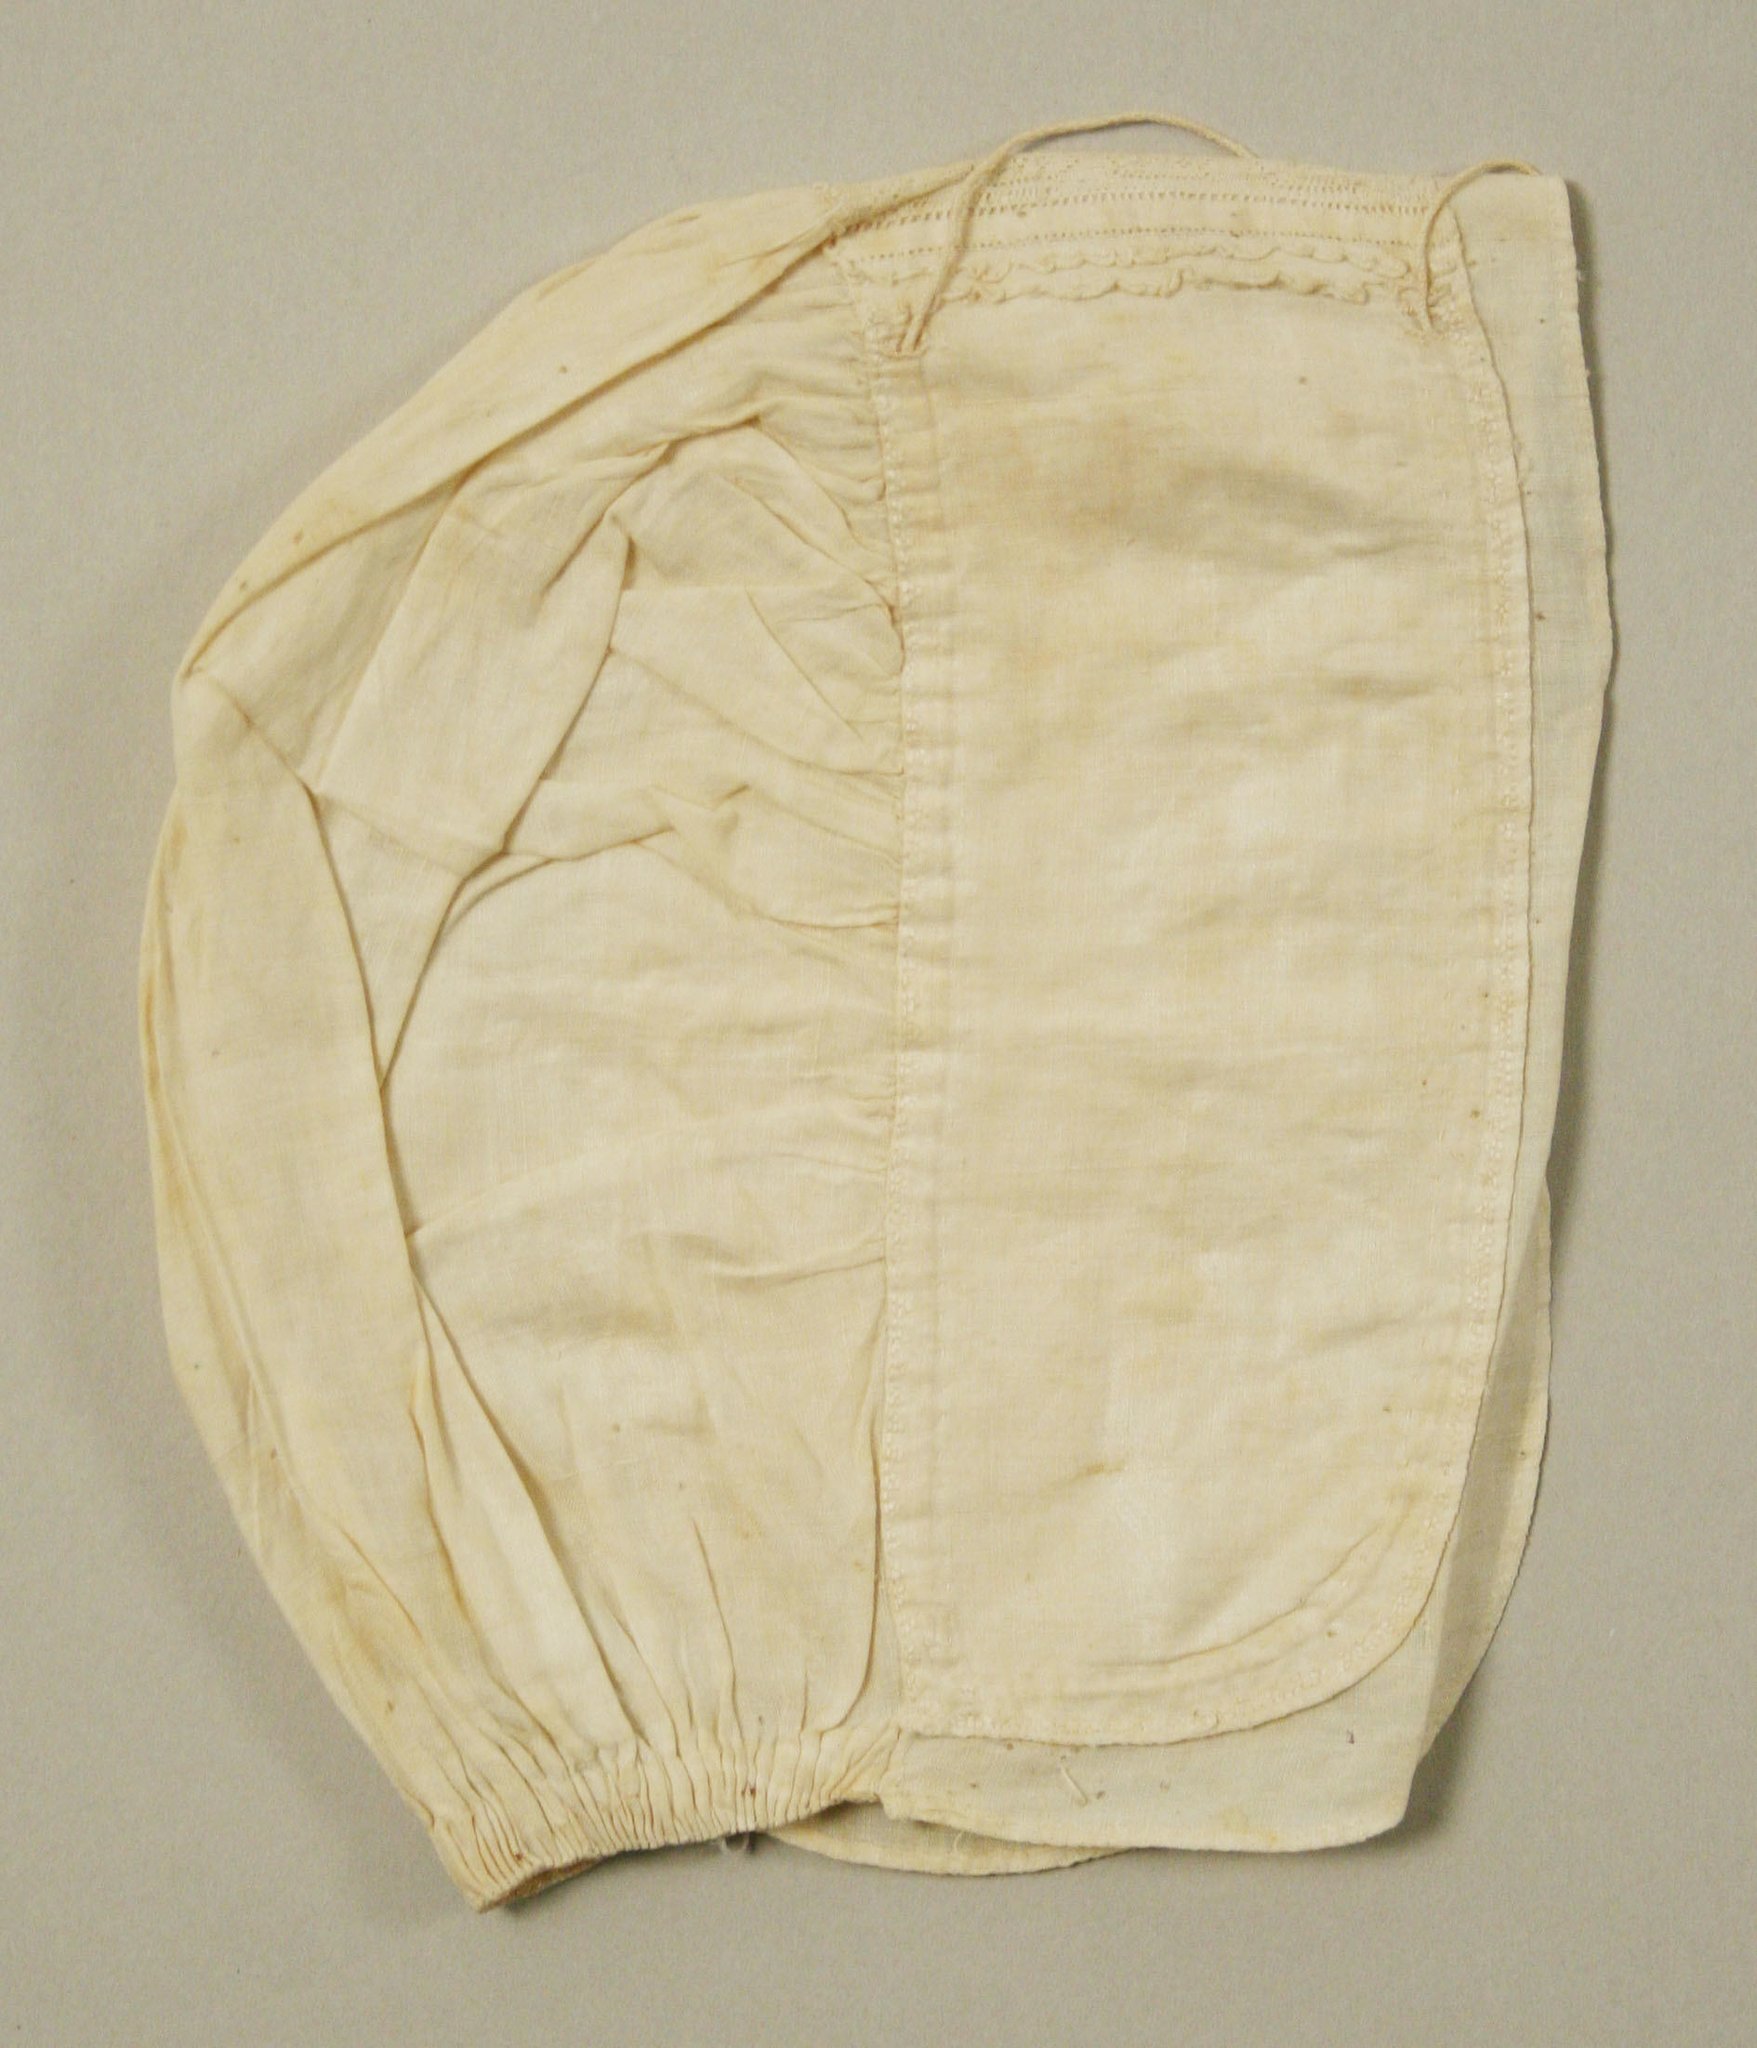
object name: cap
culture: british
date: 1701-1800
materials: linen